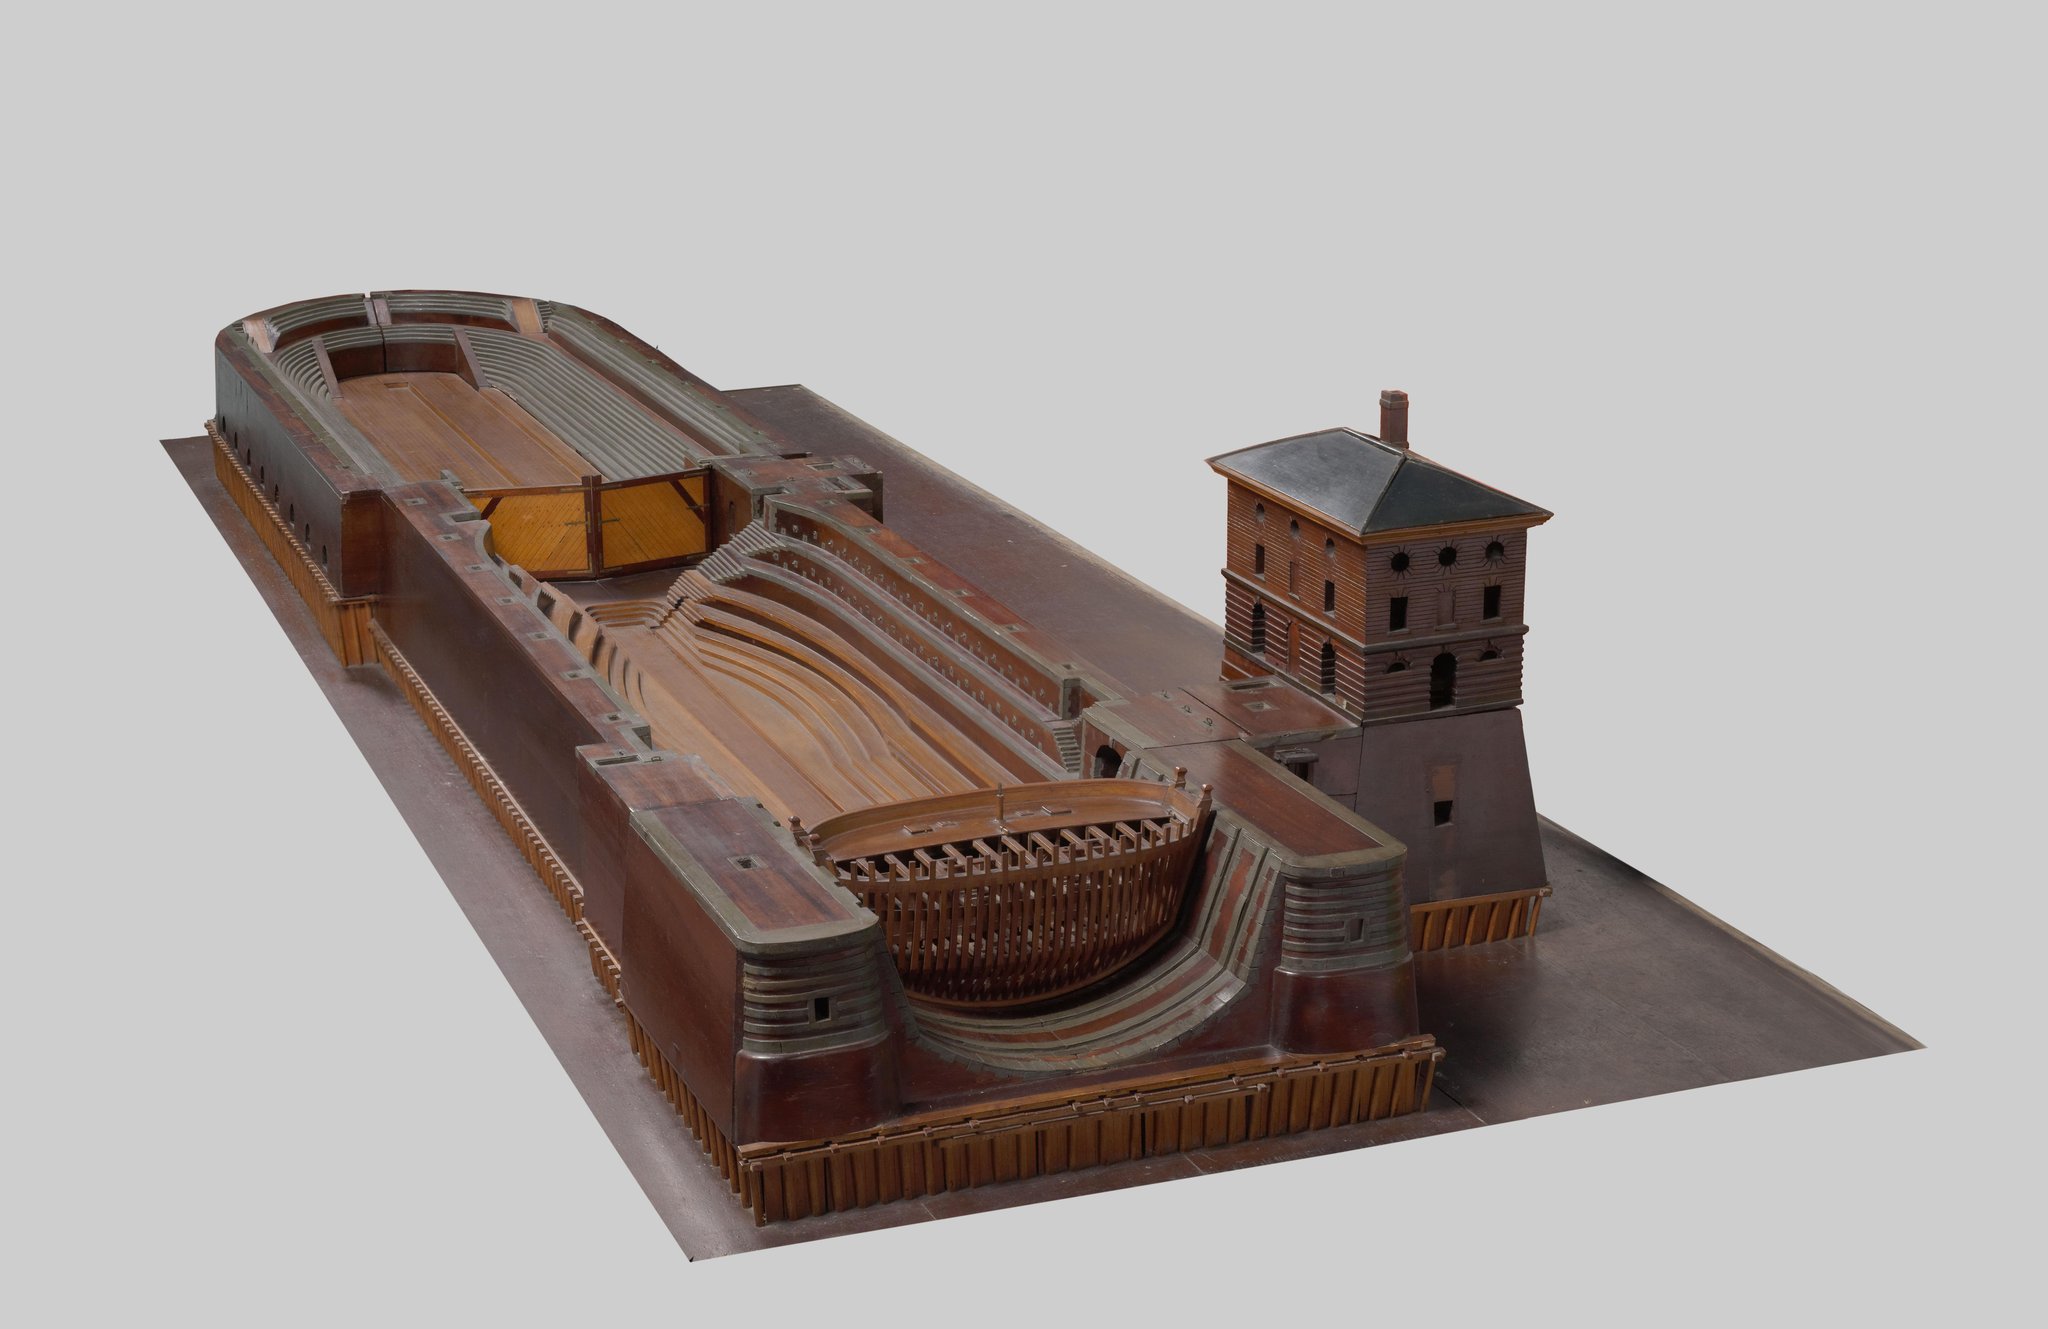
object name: presentation model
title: Model of the Double Dry Dock at Hellevoetsluis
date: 1805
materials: wood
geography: netherlands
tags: hellevoetsluis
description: Model van twee achter elkaar geplaatste droogdokken met het stoomgemaal naast het eerste dok, op een grondplank. De ingang heeft zes sponningen voor het opengewerkte spantmodel van de schipdeur met dubbele kiel; de ingang van het tweede dok is afgesloten met sluisdeuren. Een deel van het dak van het stoomgemaal kan worden verwijderd. Het gehele dok en de bijgebouwen zijn onderheid. Schaal ca. 1:50 (afgeleid).